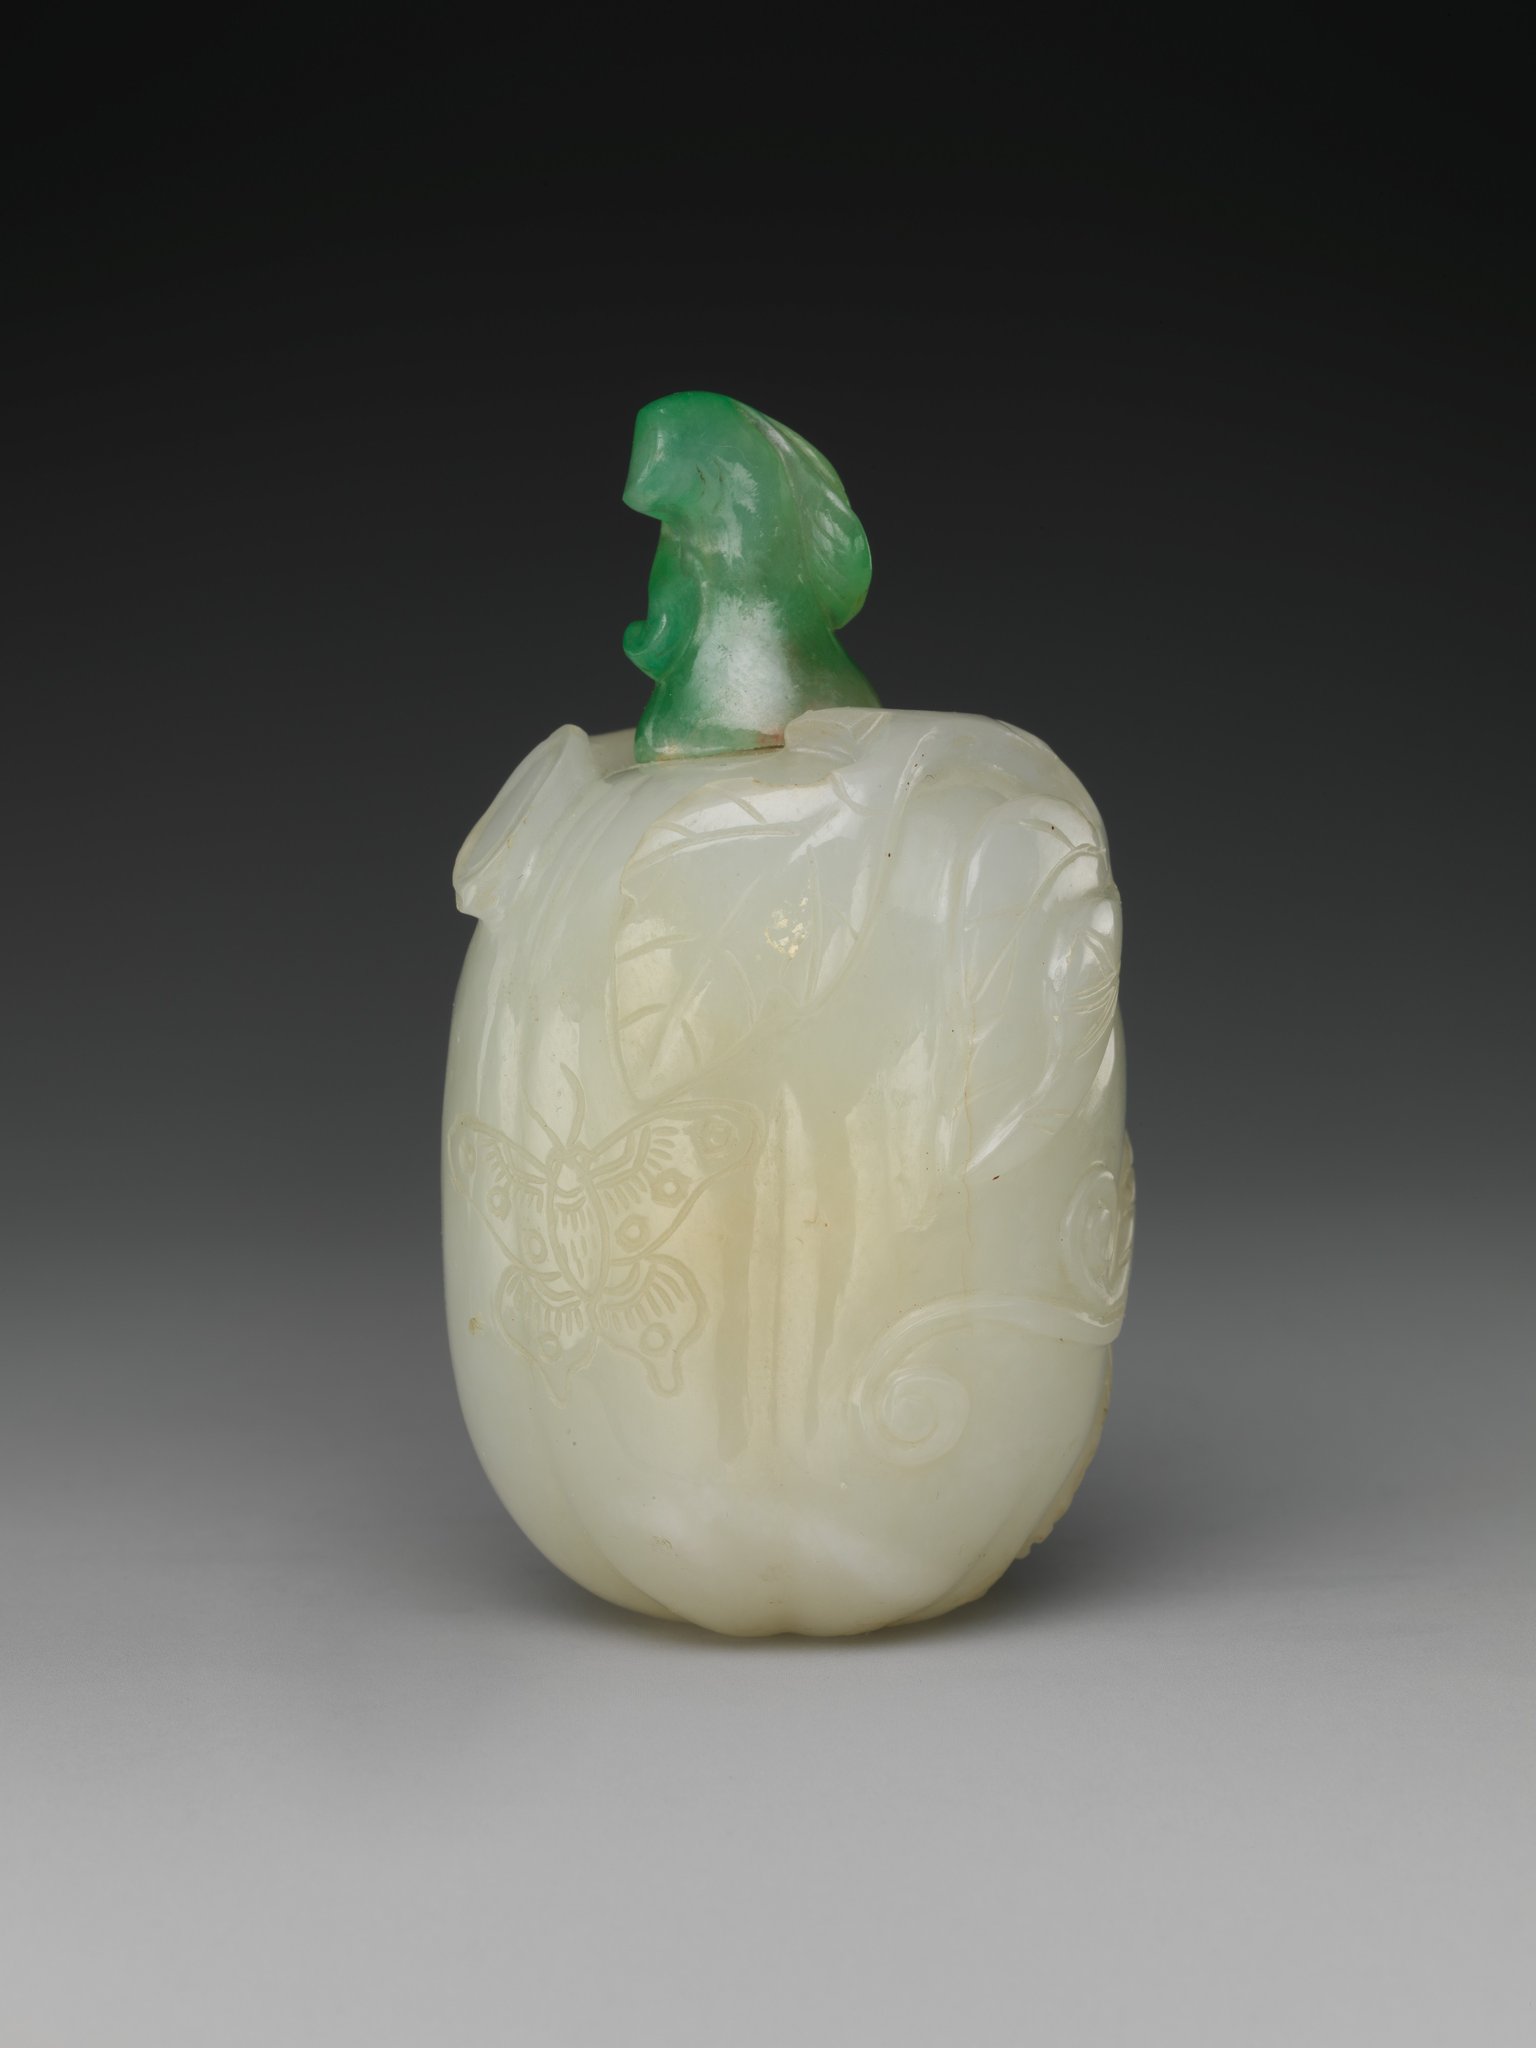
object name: snuff bottle with stopper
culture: chinese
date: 1736-1795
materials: jade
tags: butterflies